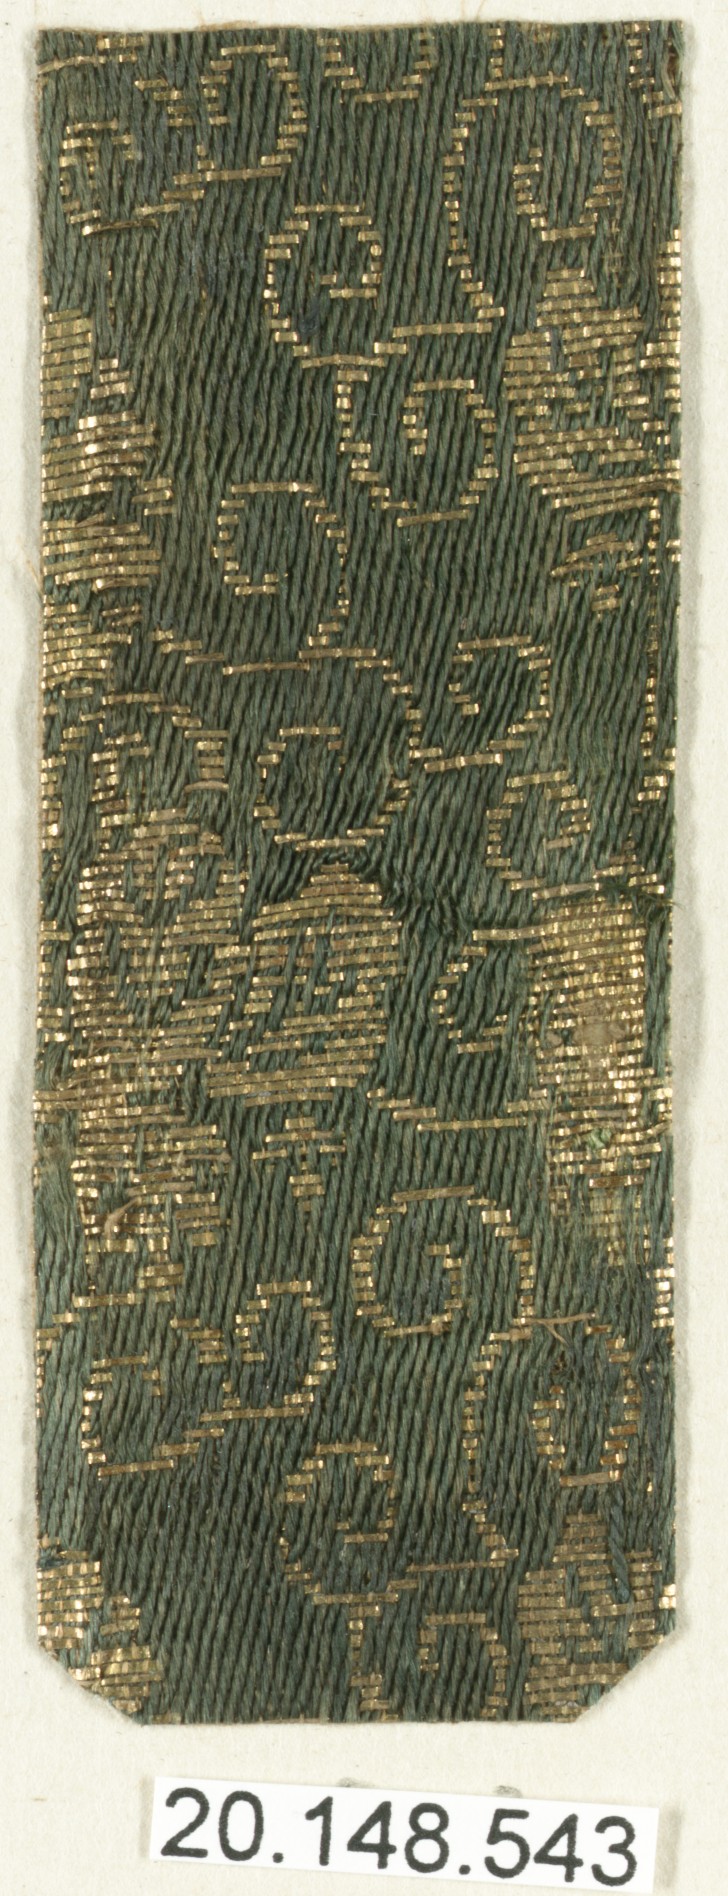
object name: piece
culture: chinese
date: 1701-1800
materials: silk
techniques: compound weave